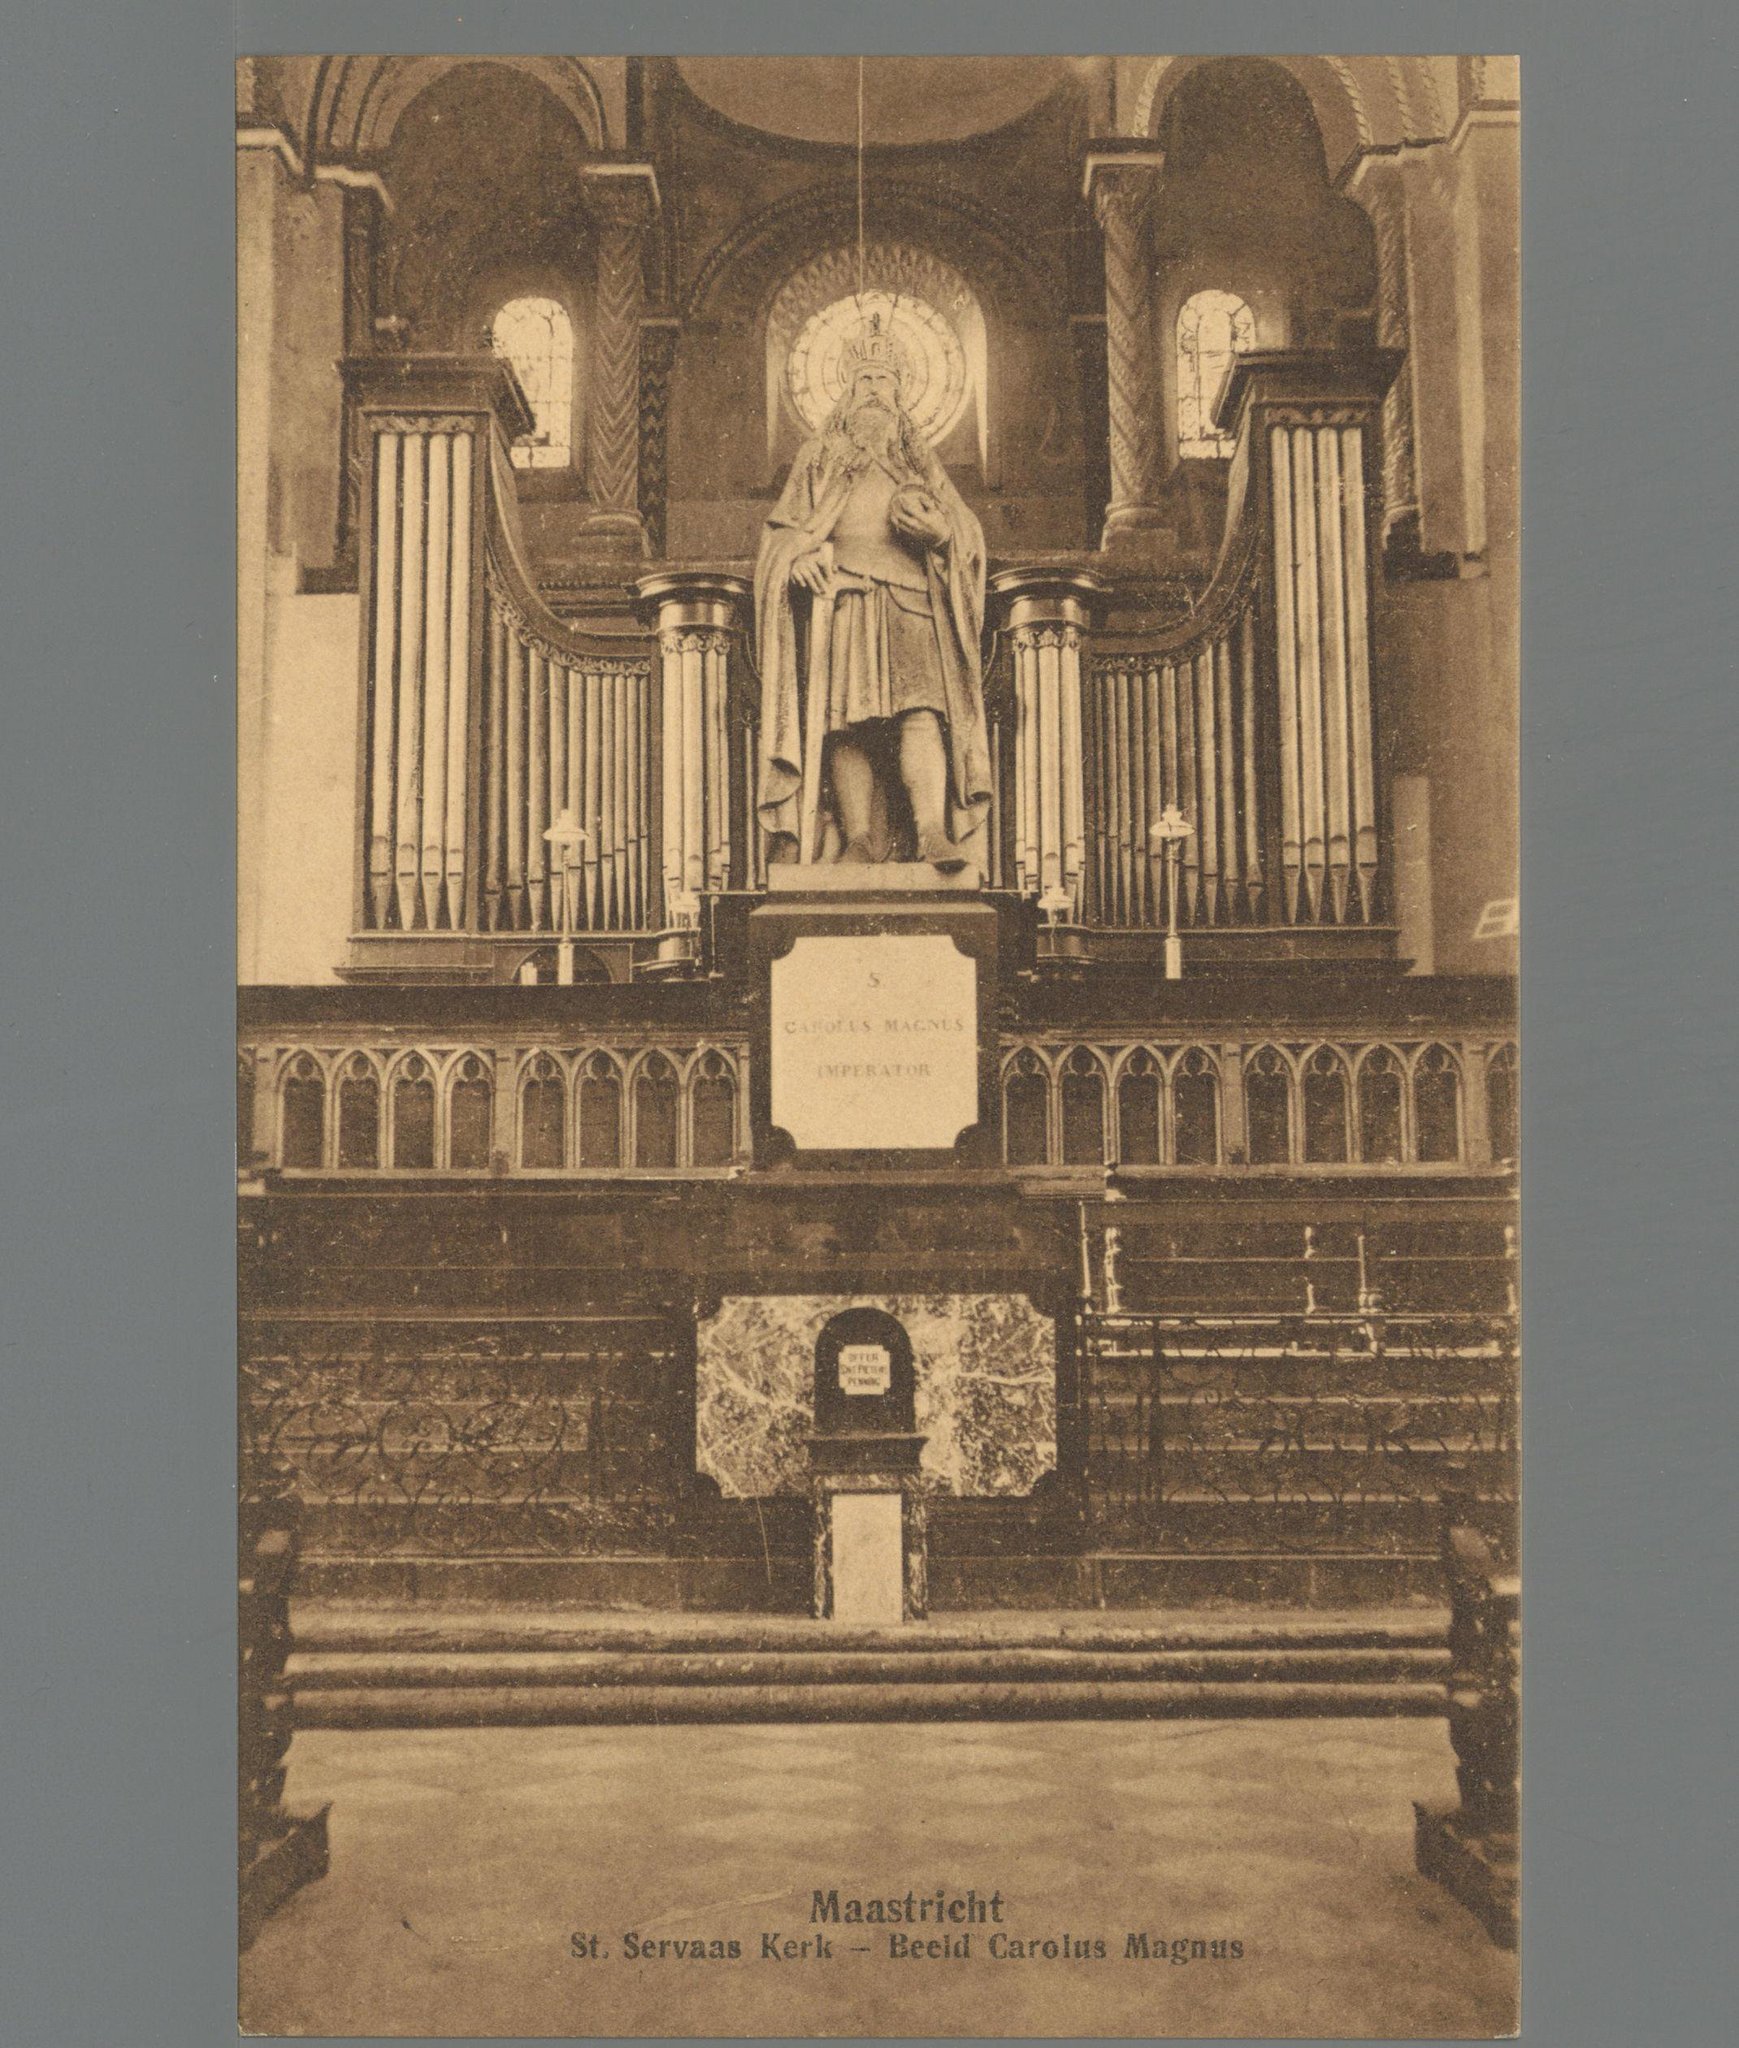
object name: photomechanical print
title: Maastricht. St. Servaas Kerk - Beeld Carolus Magnus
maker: Anonymous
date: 1912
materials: cardboard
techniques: photograph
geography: maastricht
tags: interior of church, monument, statue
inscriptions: date